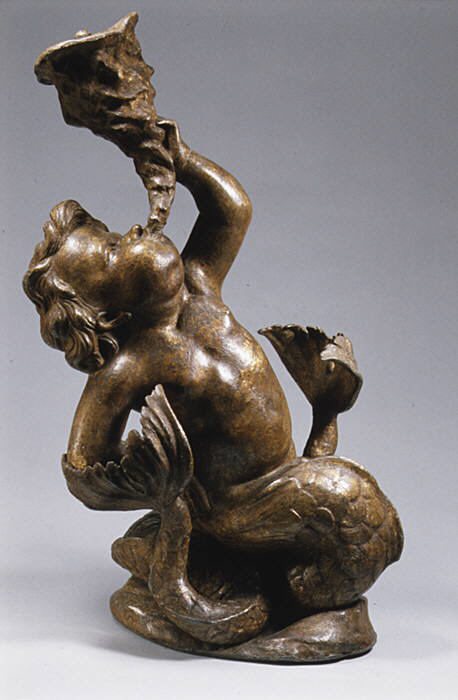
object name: fountain statuette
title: Boy Triton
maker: leonardus quesi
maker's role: maker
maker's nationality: french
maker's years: 1650-1750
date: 1710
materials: gilt, lead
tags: boys,triton